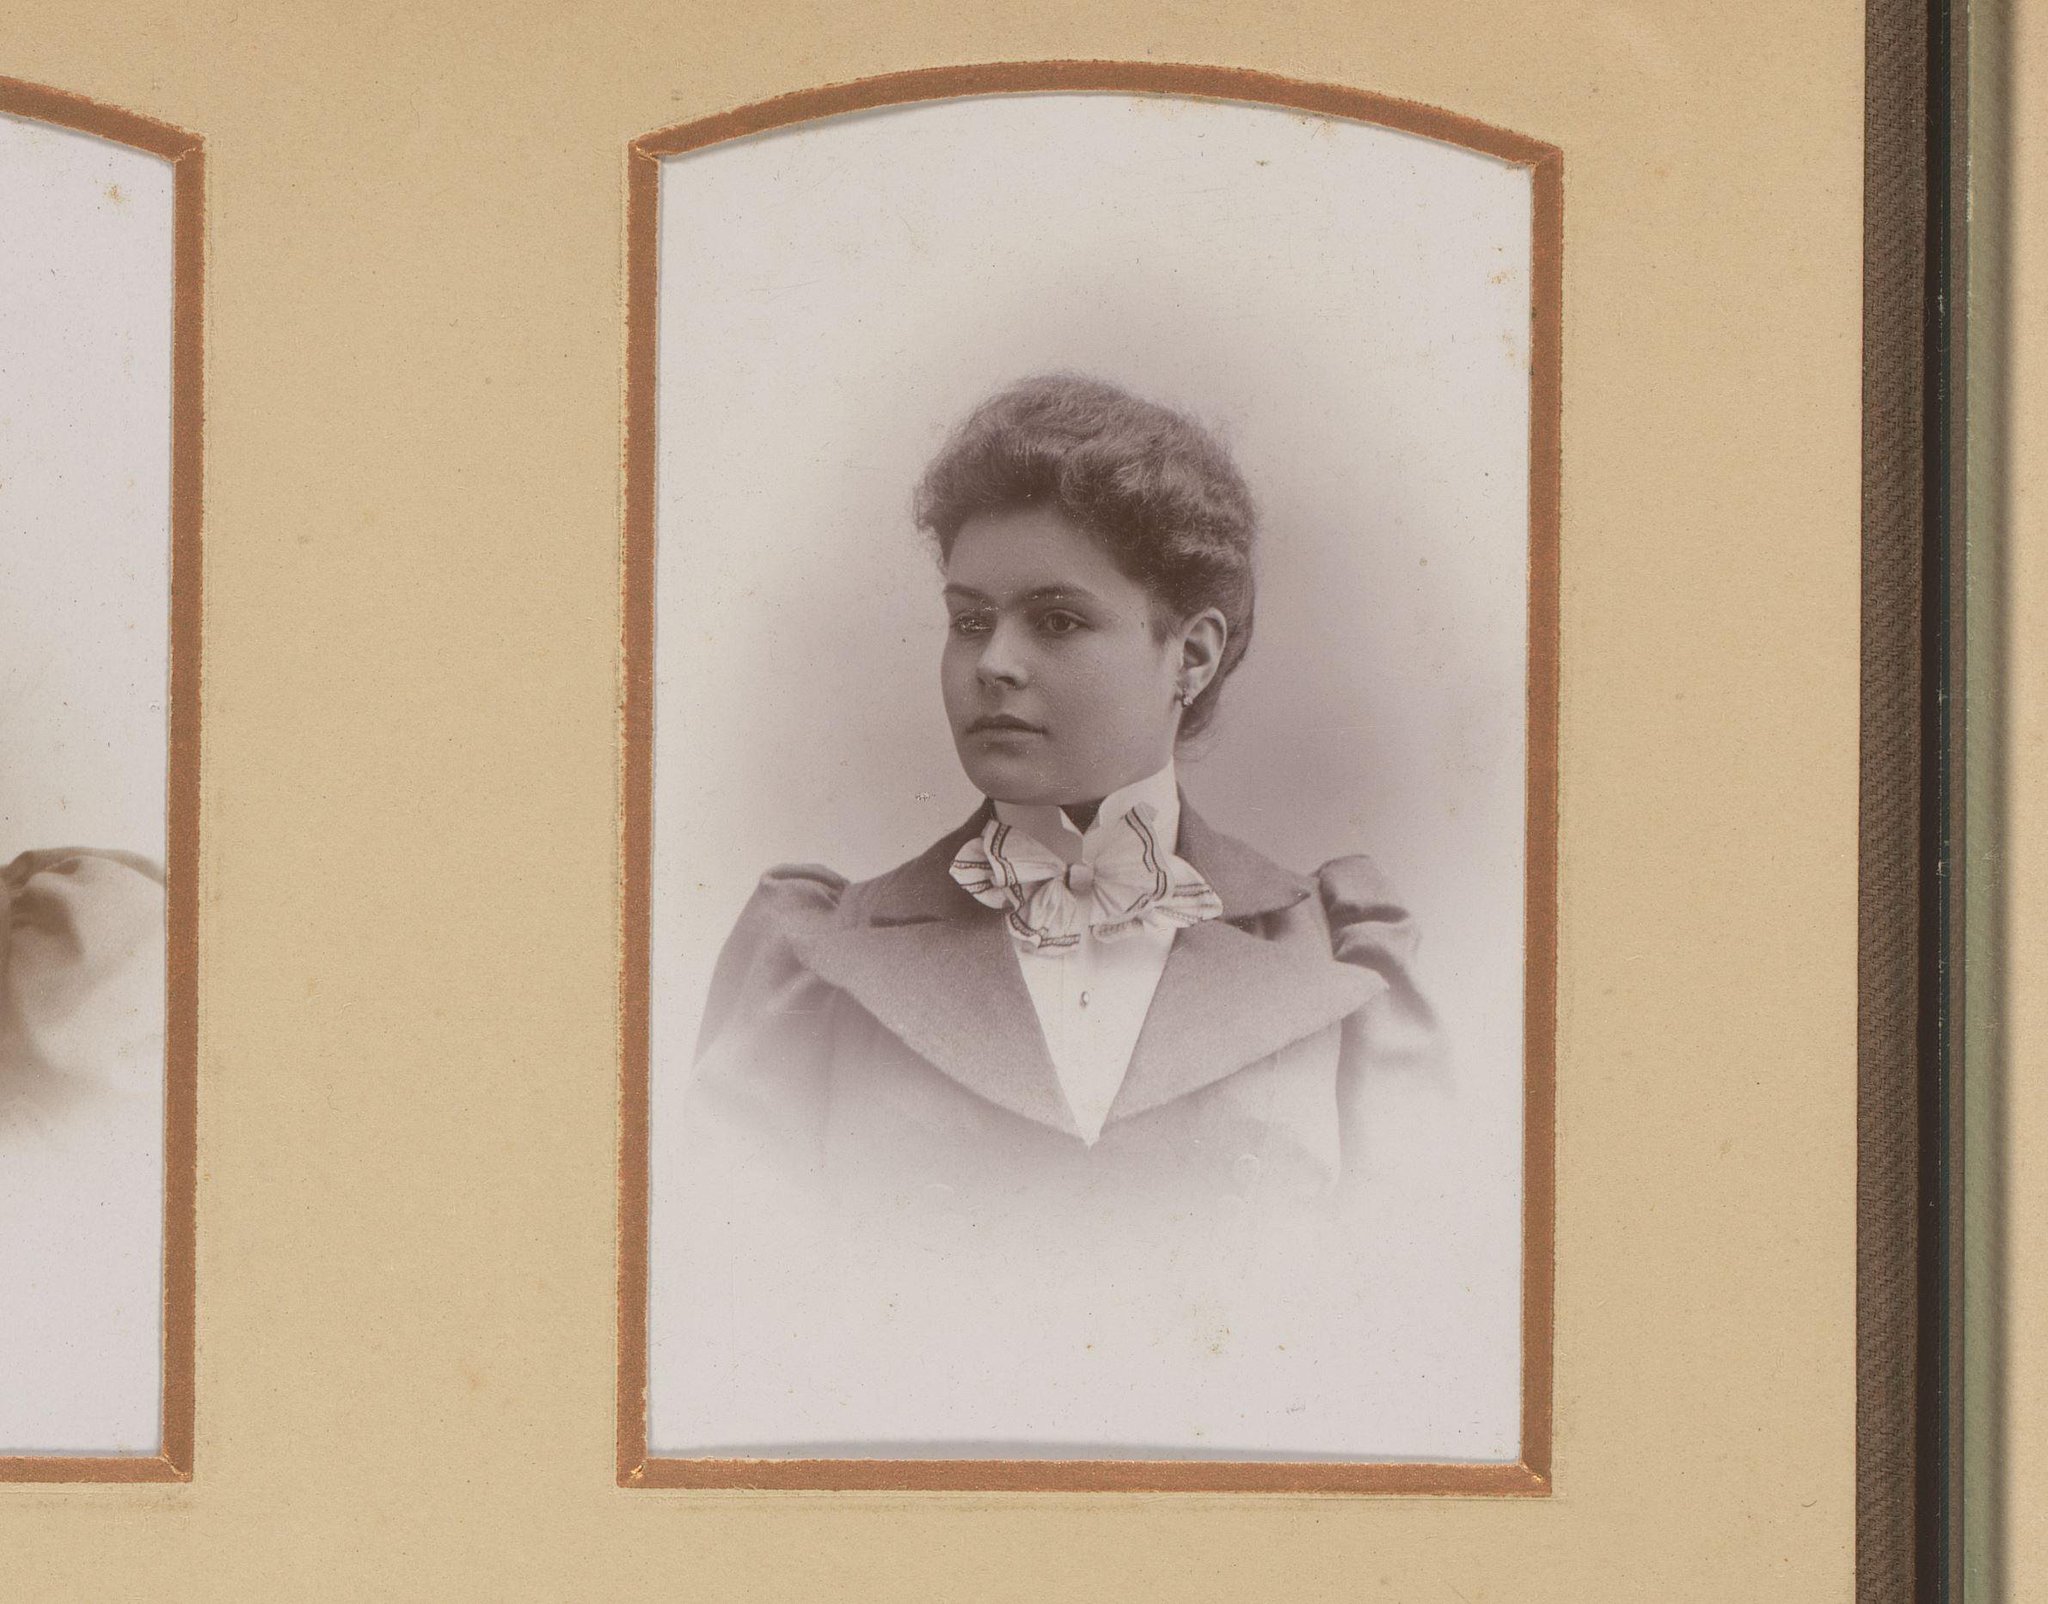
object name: album leaf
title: Portret van een jonge vrouw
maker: machiel hendricus laddé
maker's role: fotograaf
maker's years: 1866-1932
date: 1892-1906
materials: cardboard, photographic support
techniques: collodion silver print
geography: amsterdam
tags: historical persons - bb - woman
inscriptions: inscription: ‘No..../ Photographe/ Artistique/ M. H. Laddé/ boven de Firma/ Merkelbach & Co./ Amsterdam/ Nieuwendijk 57-59./ Het Cliche wordt voor verdere bestellingen bewaard.’